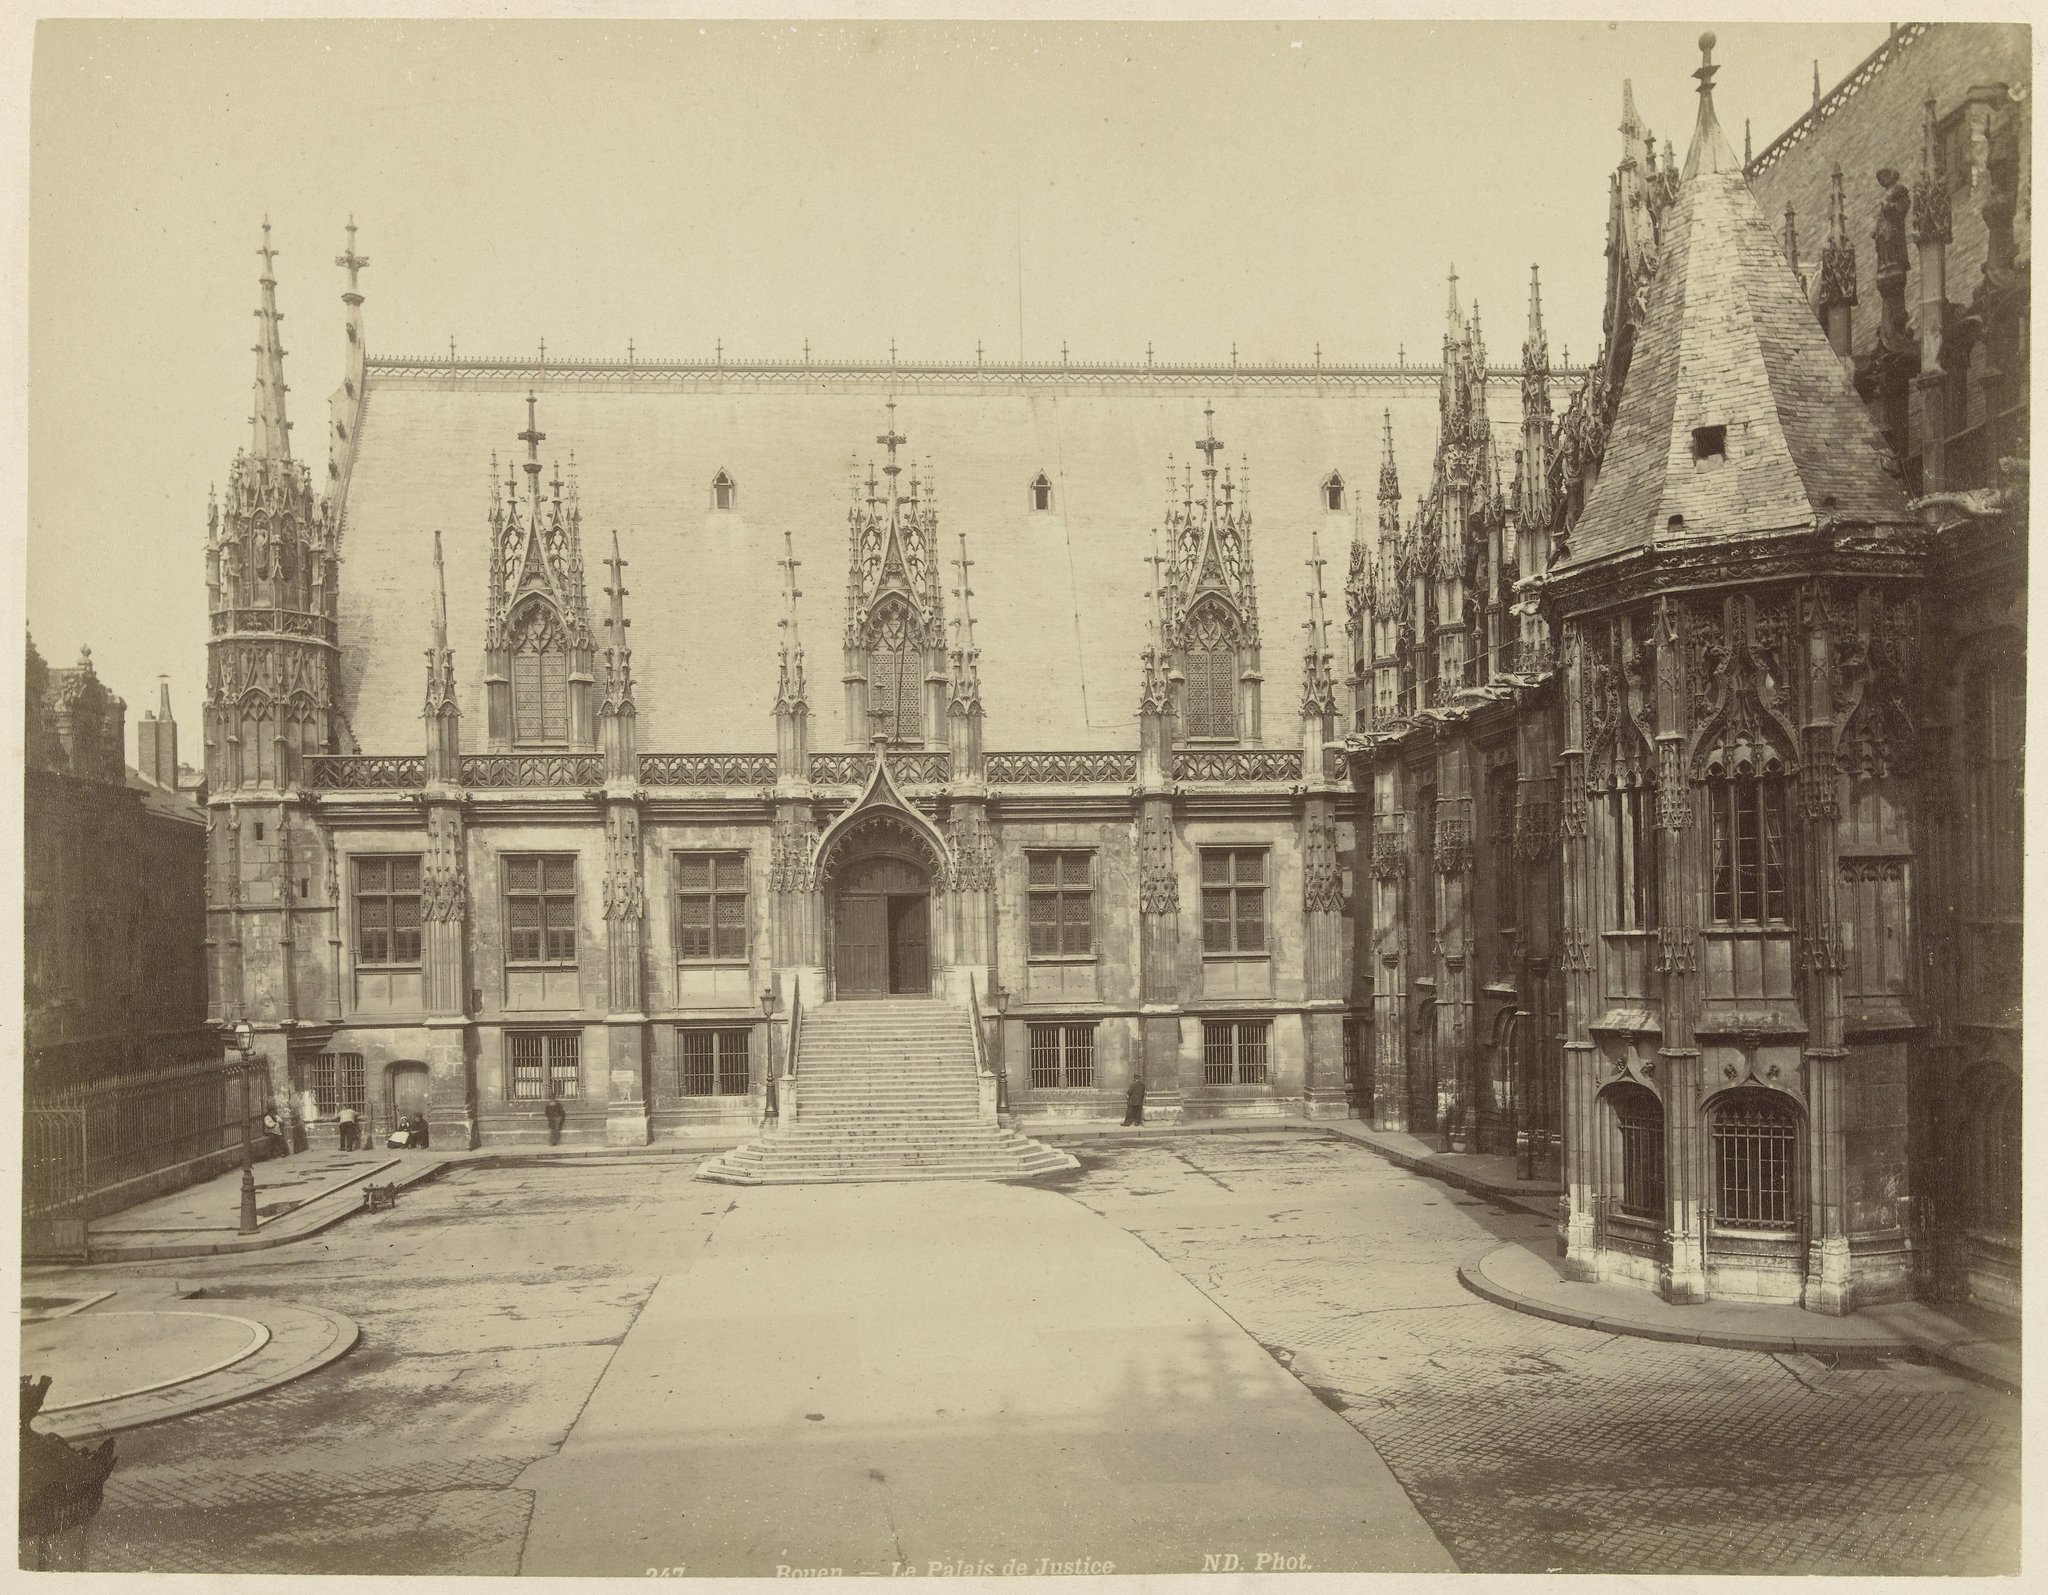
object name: photograph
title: Paleis van Justitie te Rouen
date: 1863-1900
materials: cardboard, paper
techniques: albumen print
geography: rouen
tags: court building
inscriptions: inscription: ‘247 Rouen - Le Palais de Justice ND. Phot.’